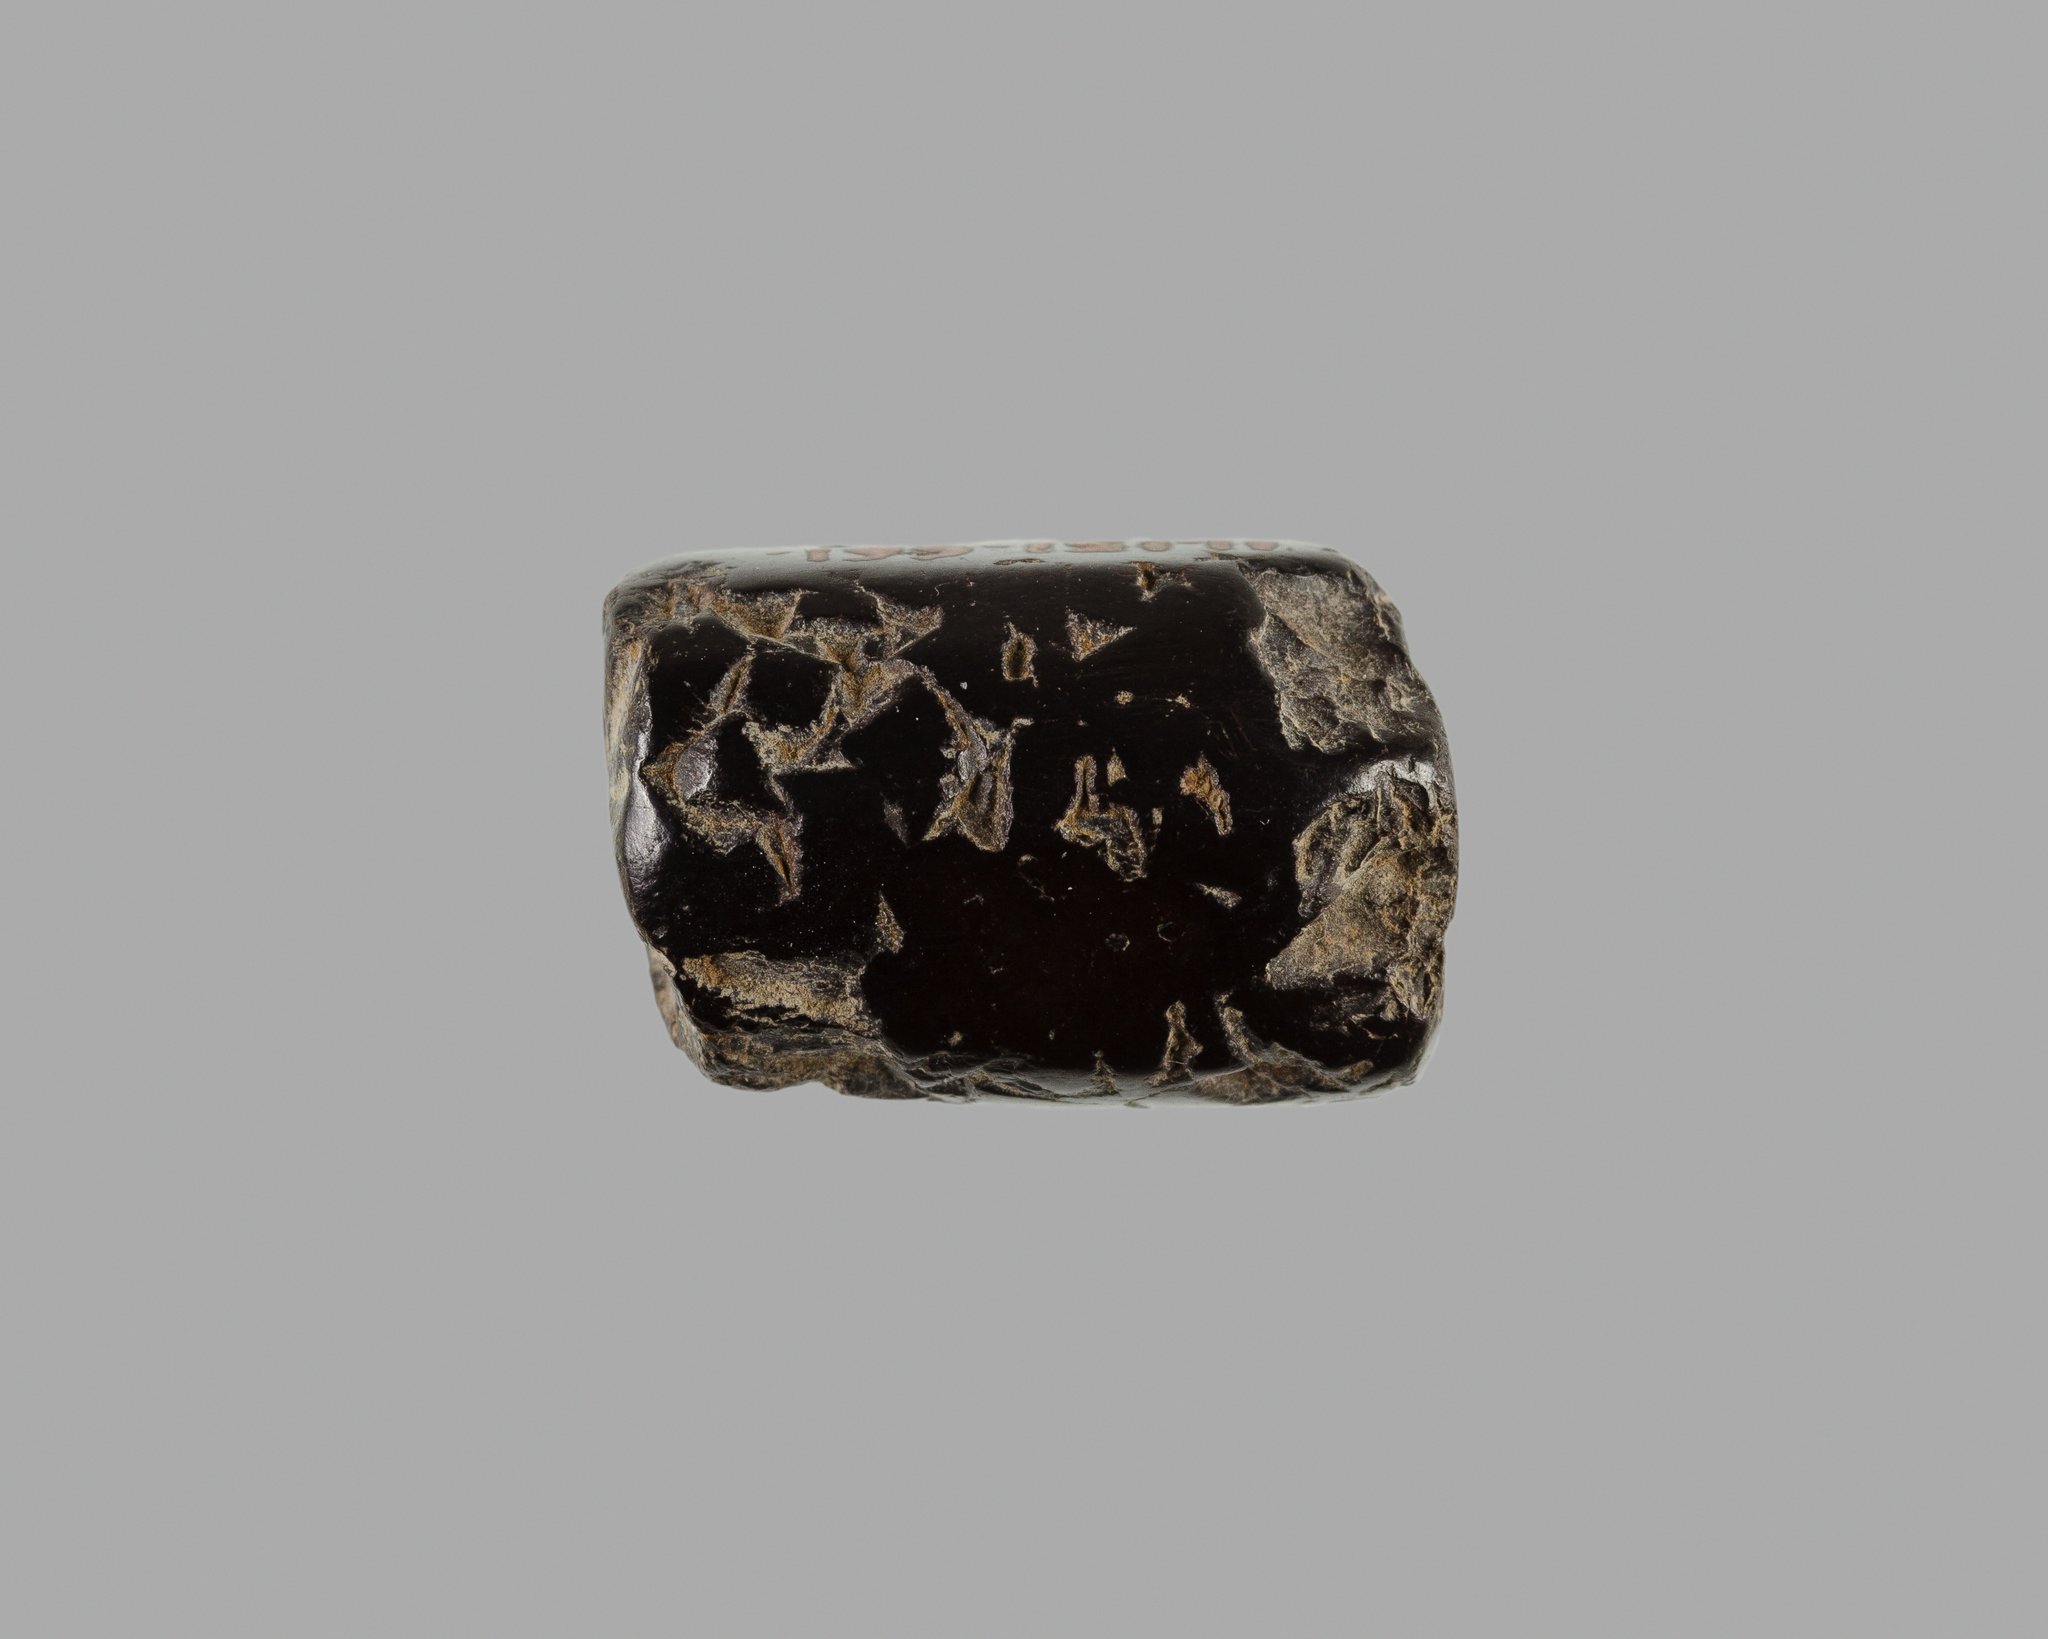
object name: cylinder seal or bead, unfinished or reused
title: Polygonal cylinder seal; possibly reworked at a later date; possibly inscribed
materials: mineral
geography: egypt